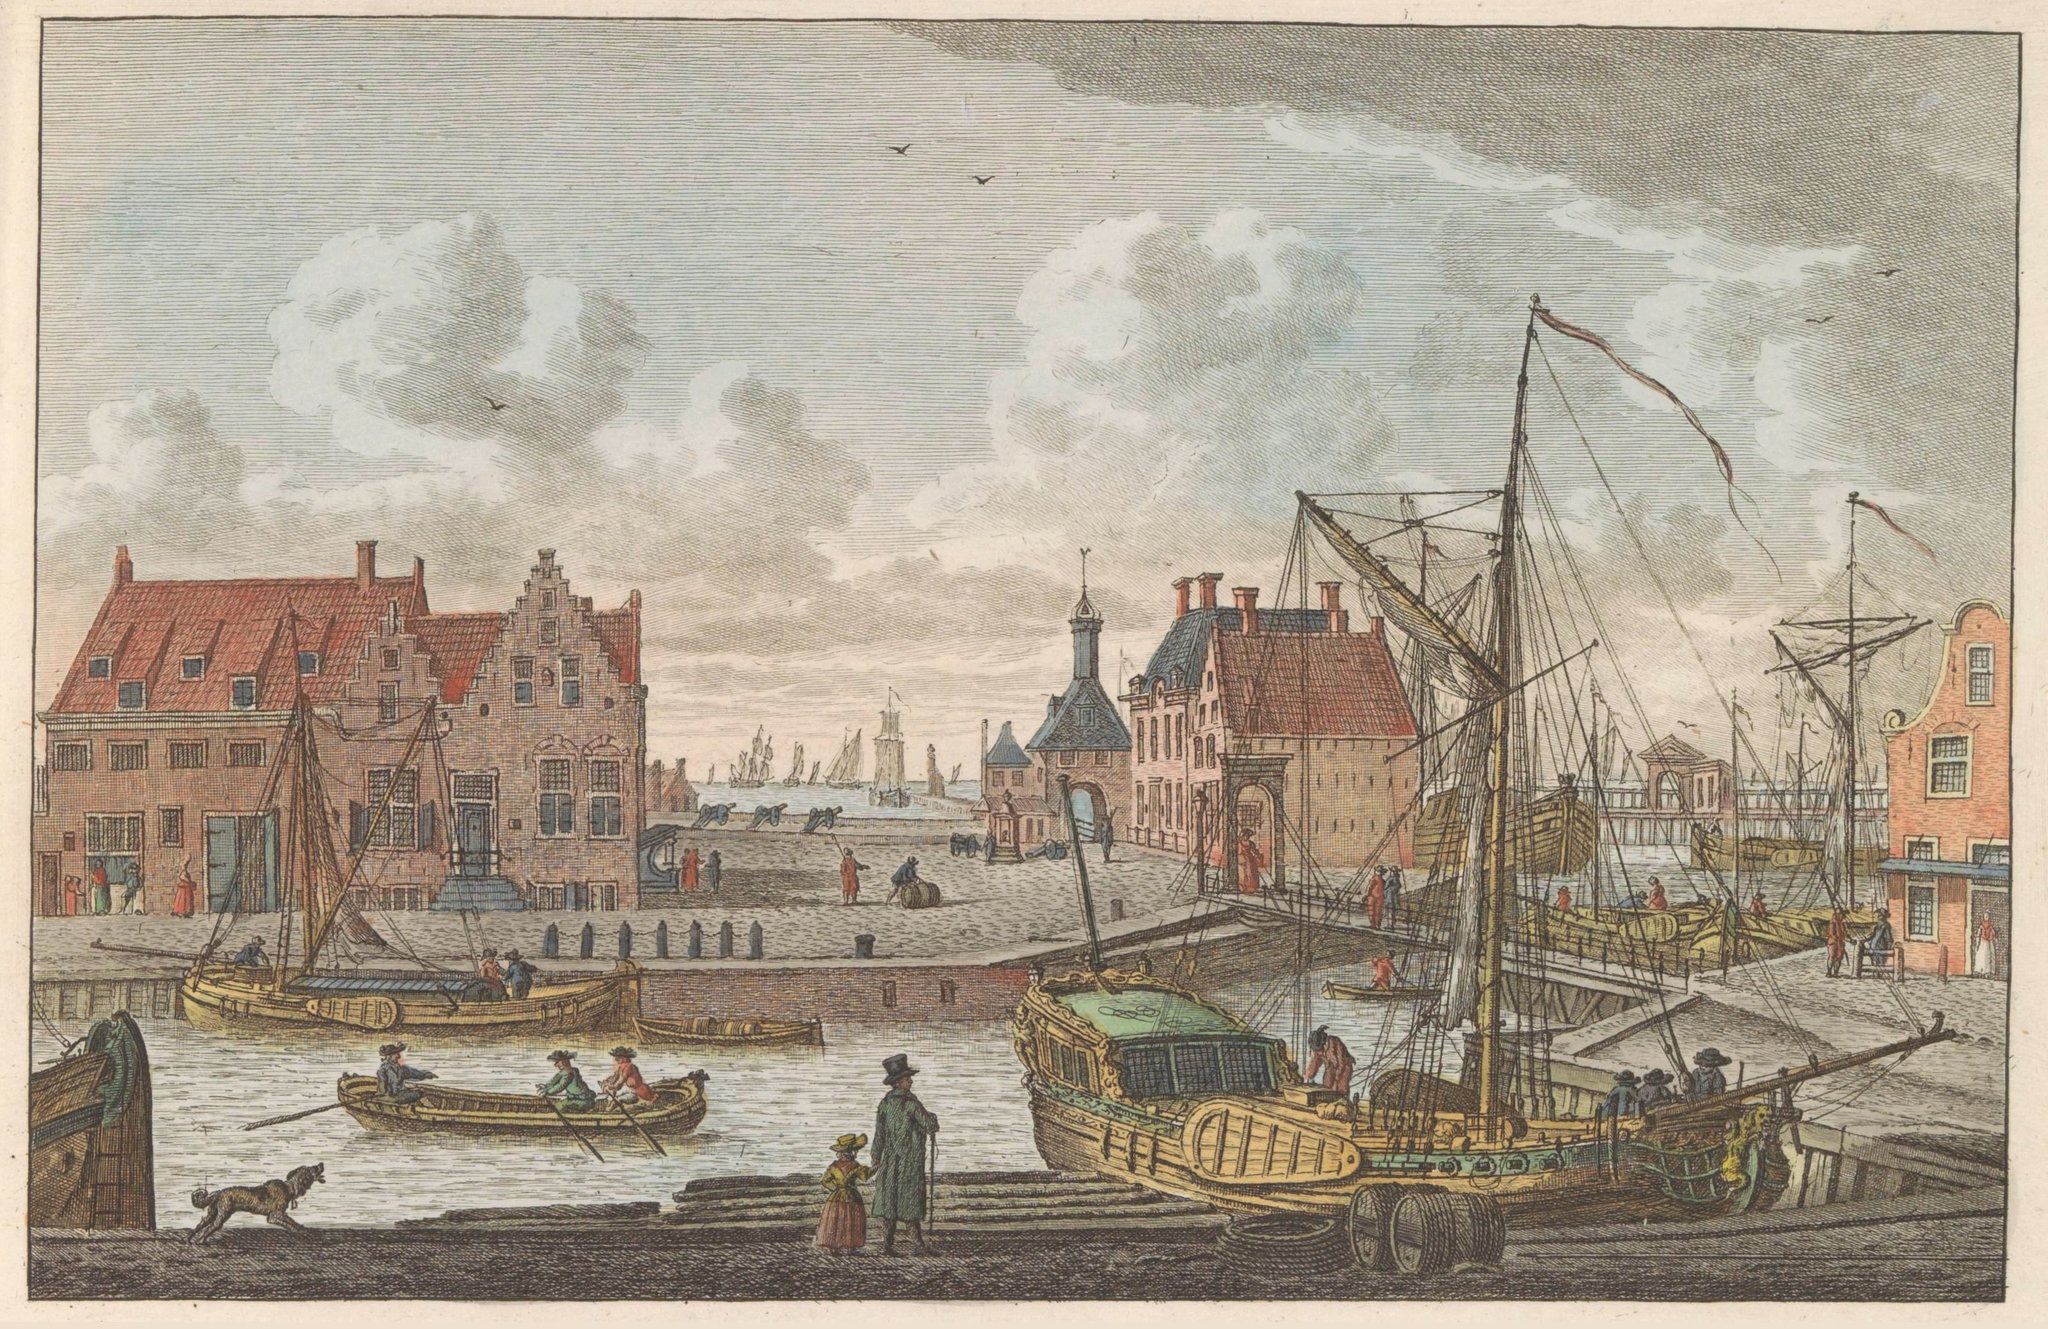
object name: print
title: Havenpoort van Harlingen, ca. 1790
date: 1786-1792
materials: paper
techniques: engraving, etching, hand coloring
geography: amsterdam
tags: harbour, harlingen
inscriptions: inscription: ‘chez E: Maaskamp à Amsterdam’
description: Huidige staat van prent uitgegeven als onderdeel van een plaatwerk uit ca. 1824-1825 met 74 (ongenummerde) platen van de belangrijkste topografische gezichten en verschillende zeden en gewoonten in het Verenigd Koninkrijk der Nederlanden, getiteld 'Tableau des principales vues des palais et édifices : représentations et des coutumes et usages, dans les provinces septentrionales du Royaume des Pays-Bas'. Eerdere staat gebruikt in: Vaderlandsche gezichten, of afbeeldingen van den tegenwoordigen staat der Vereenigde Nederlanden (…). Amsterdam: Hendrik Gartman, Willem Vermandel en Jan Willem Smit, 1786-1792. Uitgegeven in afleveringen met ieder een eigen bifolium en inhoudsopgave. Alle prenten in deze publicatie zijn gegraveerd door Carel Frederik Bendorp (I) en, in de meeste gevallen, gebaseerd op tekeningen van Jan Bulthuis.